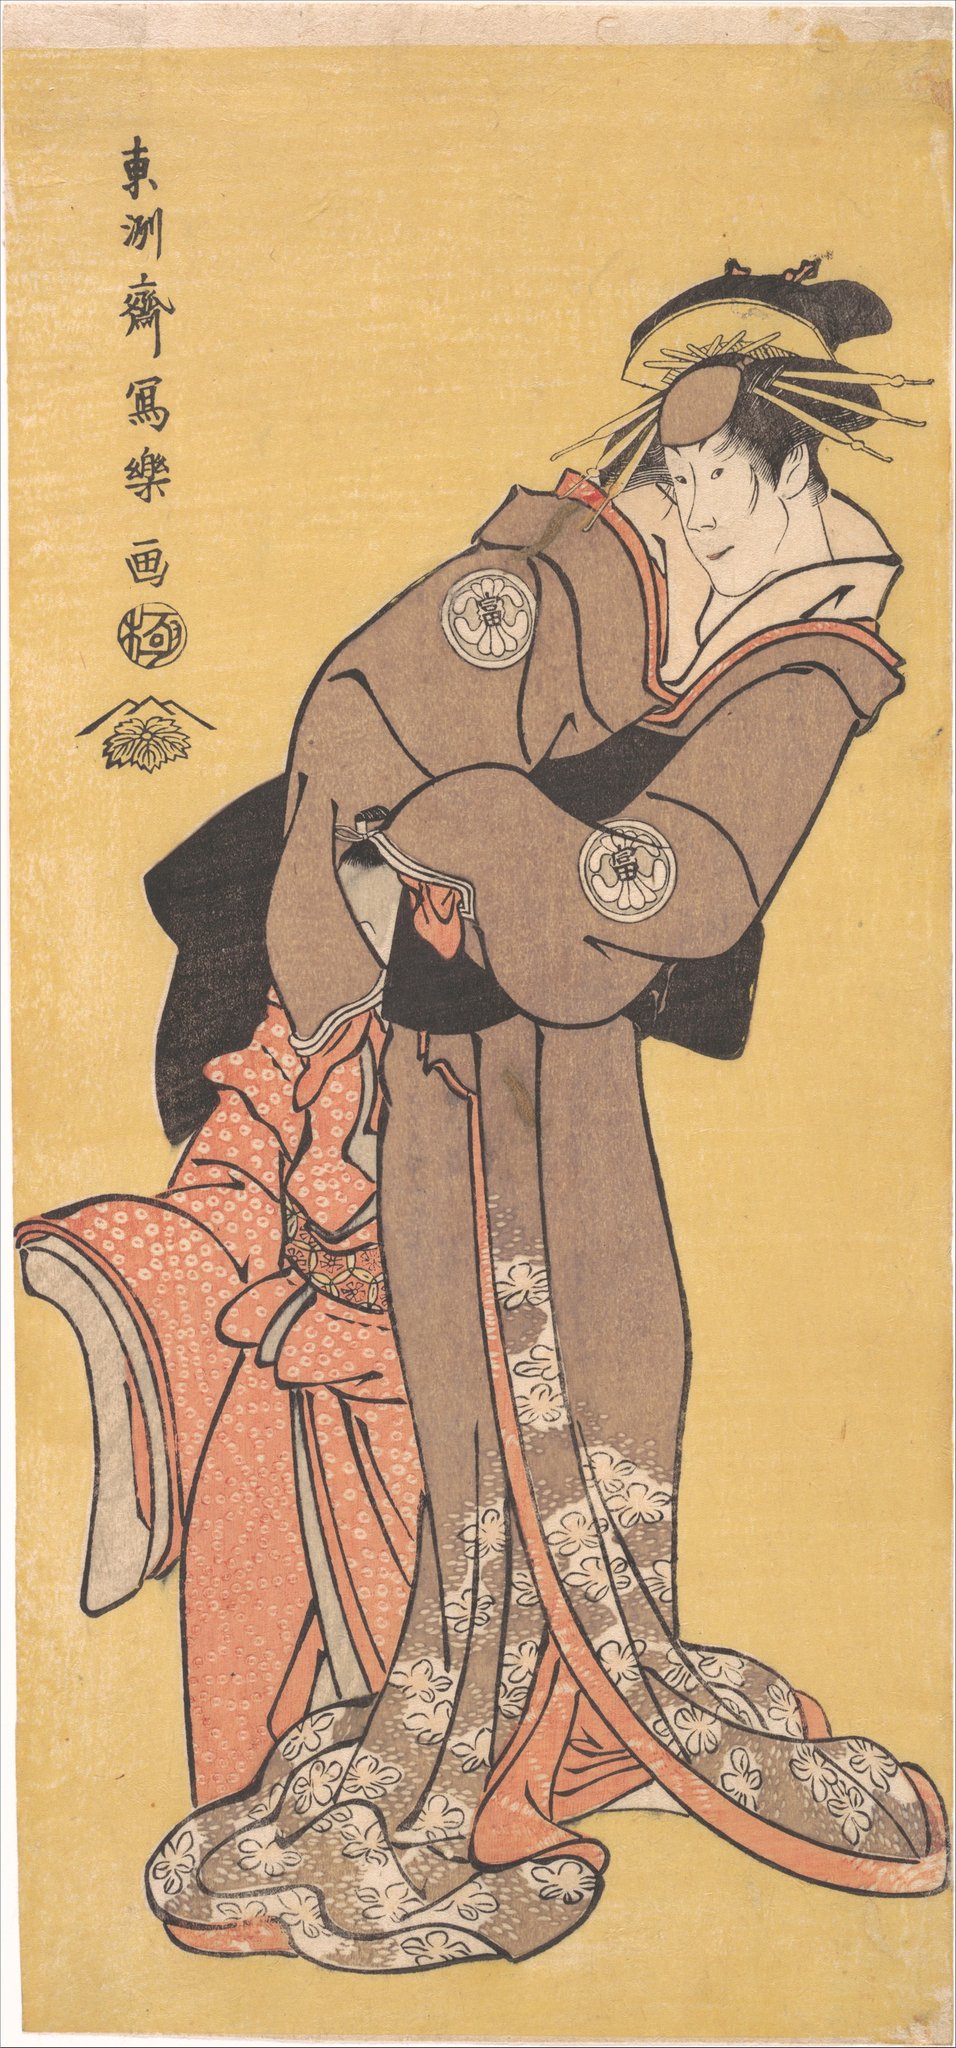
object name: print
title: Actor Segawa Tomisaburo II as the Courtesan Toyama and Actor Ichikawa Kurizo as Higashiyama Yoshiwakamaru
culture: japanese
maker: tōshūsai sharaku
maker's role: artist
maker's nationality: japanese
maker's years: 1794-1795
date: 1794-1795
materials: ink, paper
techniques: woodblock print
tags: men,women,actors